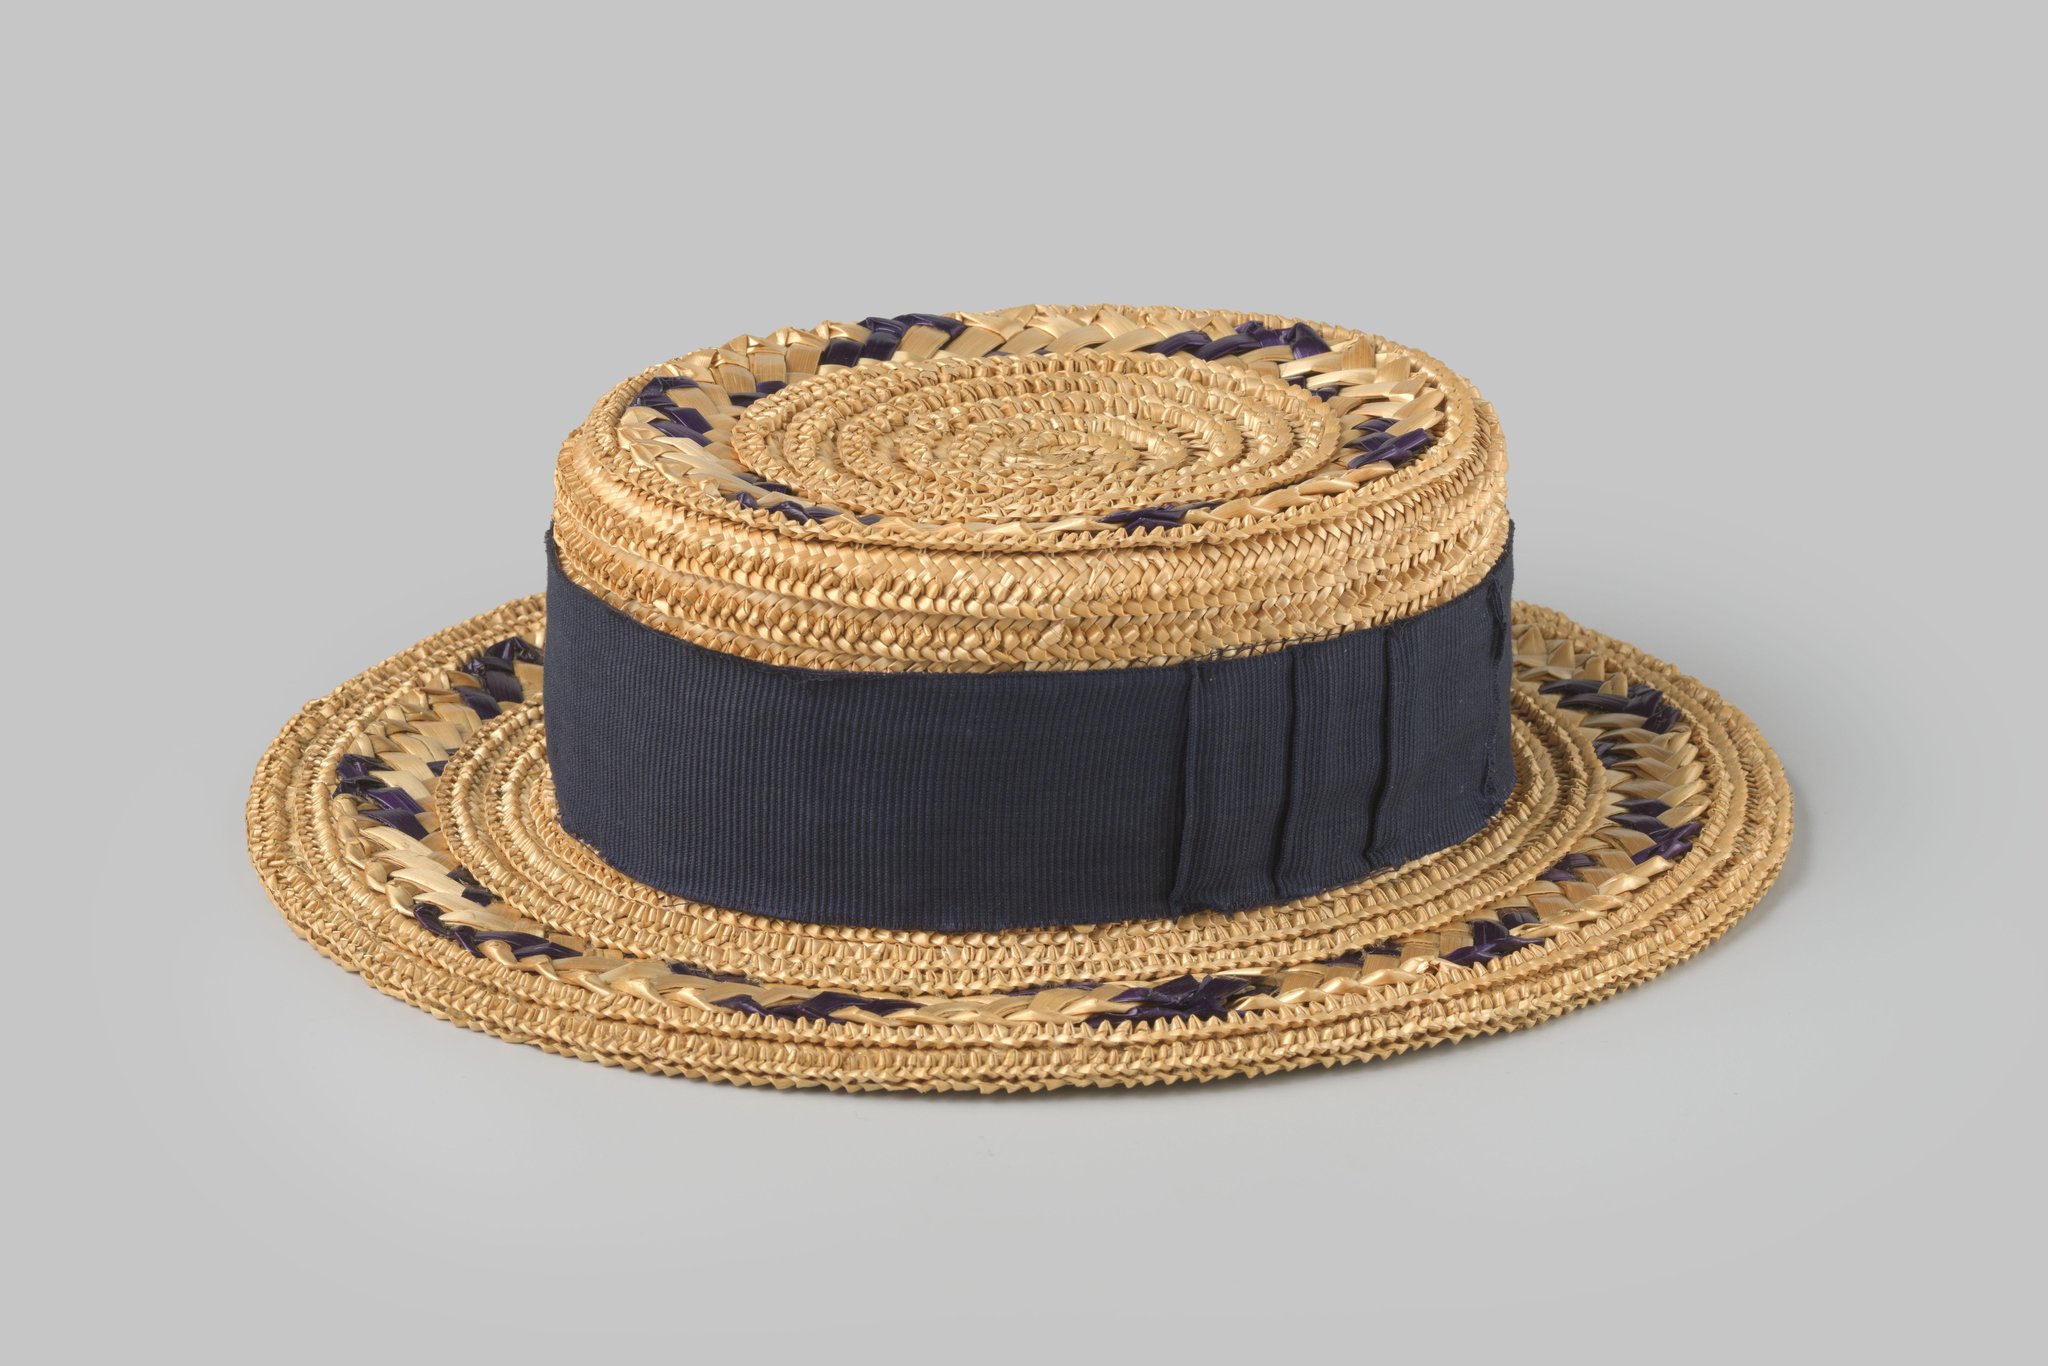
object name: straw hat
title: Strohoed van beige, met blauwe biezen ingevlochten stroband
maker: Anonymous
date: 1920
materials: paper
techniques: braiding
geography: france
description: Strohoed van beige, met blauwe biezen ingevlochten stroband, voorzien van blauw lint. Ovaal, plat. Bodempapier in vuil wit, waarop gedrukt staat: 3½.